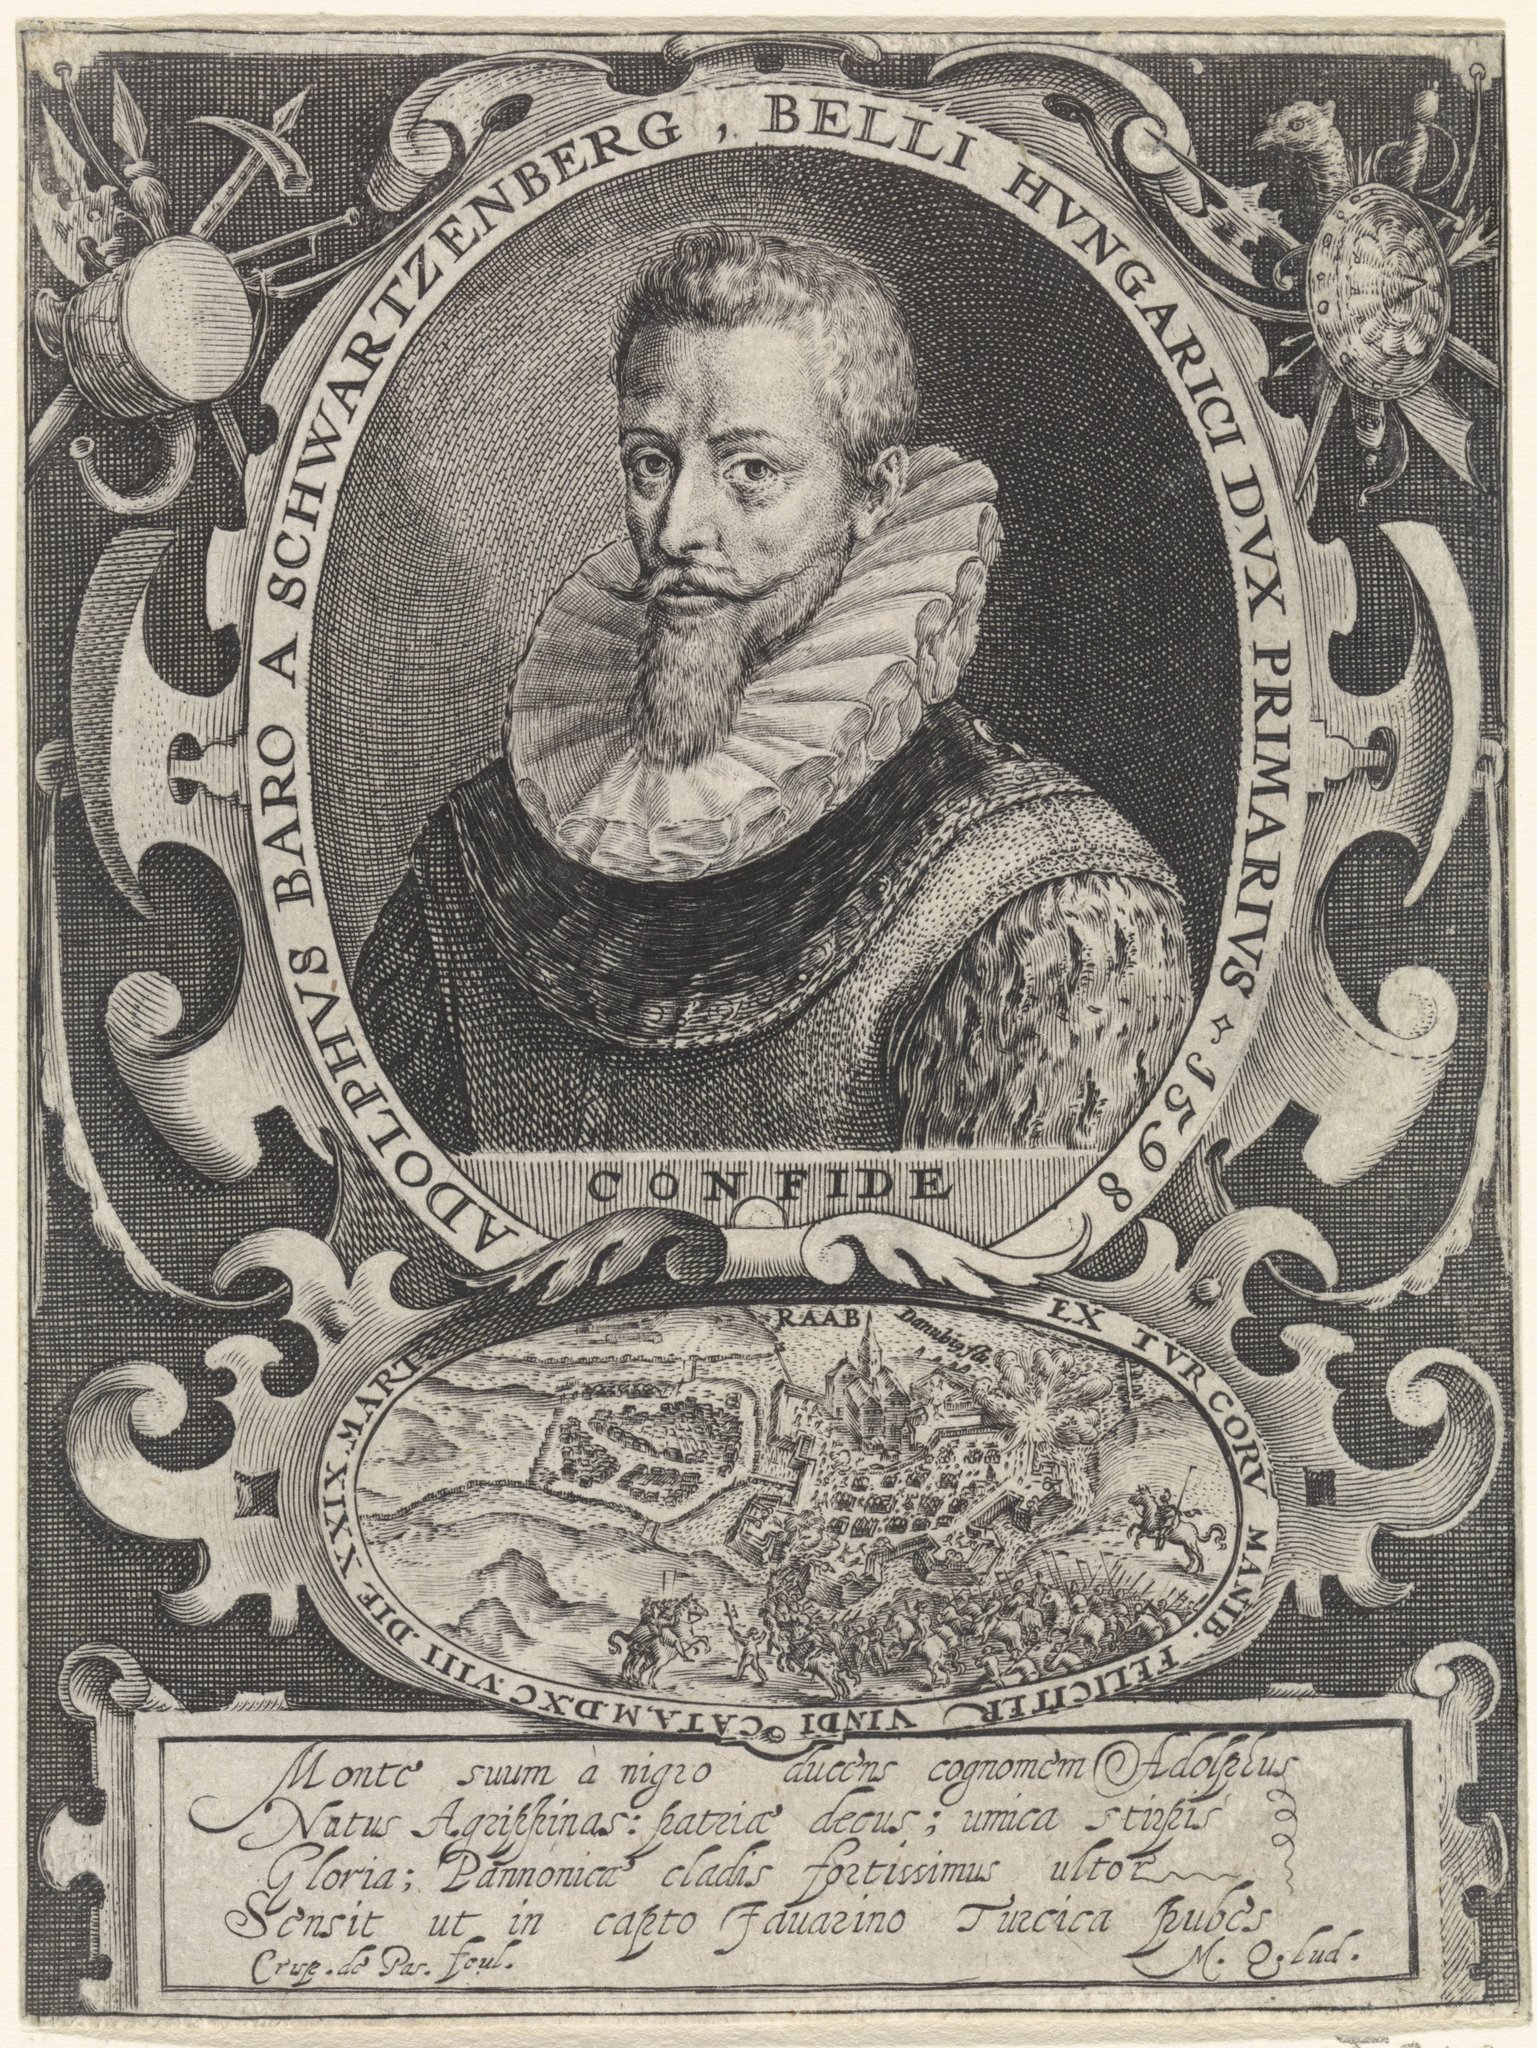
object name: print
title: Portret van Adolf von Schwarzenberg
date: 1598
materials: paper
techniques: engraving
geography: cologne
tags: adolf von schwarzenberg (graaf)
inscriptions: collector's mark: Lugt 2228, collector's mark: Lugt 1337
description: Portret van Adolf von Schwarzenberg, generaal van het Heilige Roomse Rijk, eronder zijn devies in het Latijn. Onder zijn portret een voorstelling van één van zijn belangrijkste militaire prestaties: de herovering van Raab in 1598. In een cartouche een vierregelig lofdicht in het Latijn.